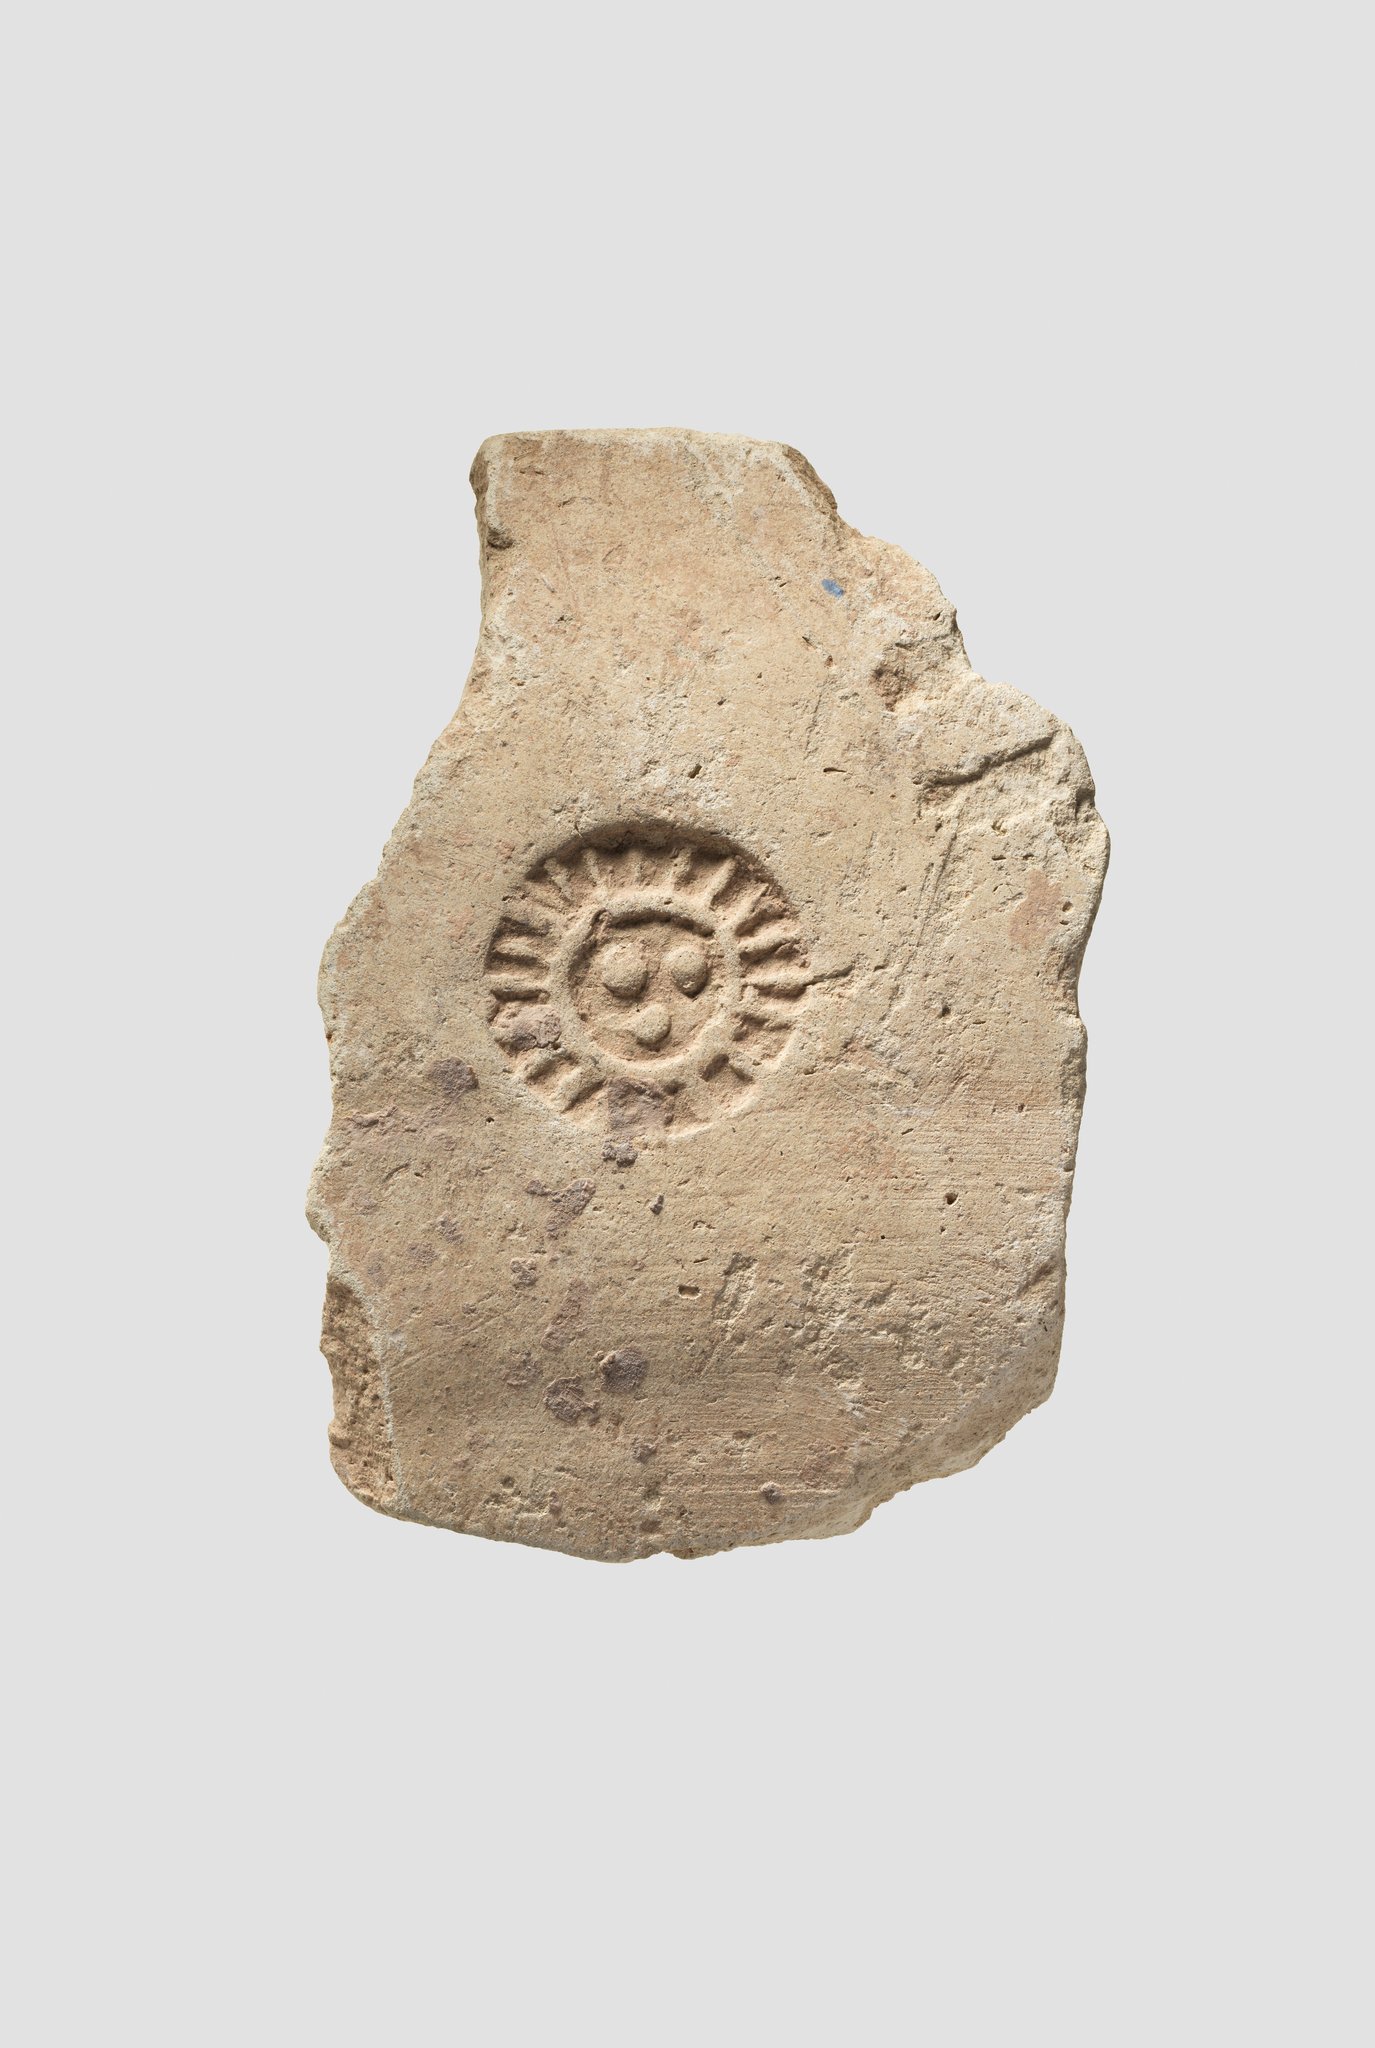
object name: sherd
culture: sasanian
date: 201-700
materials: ceramic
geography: mesopotamia